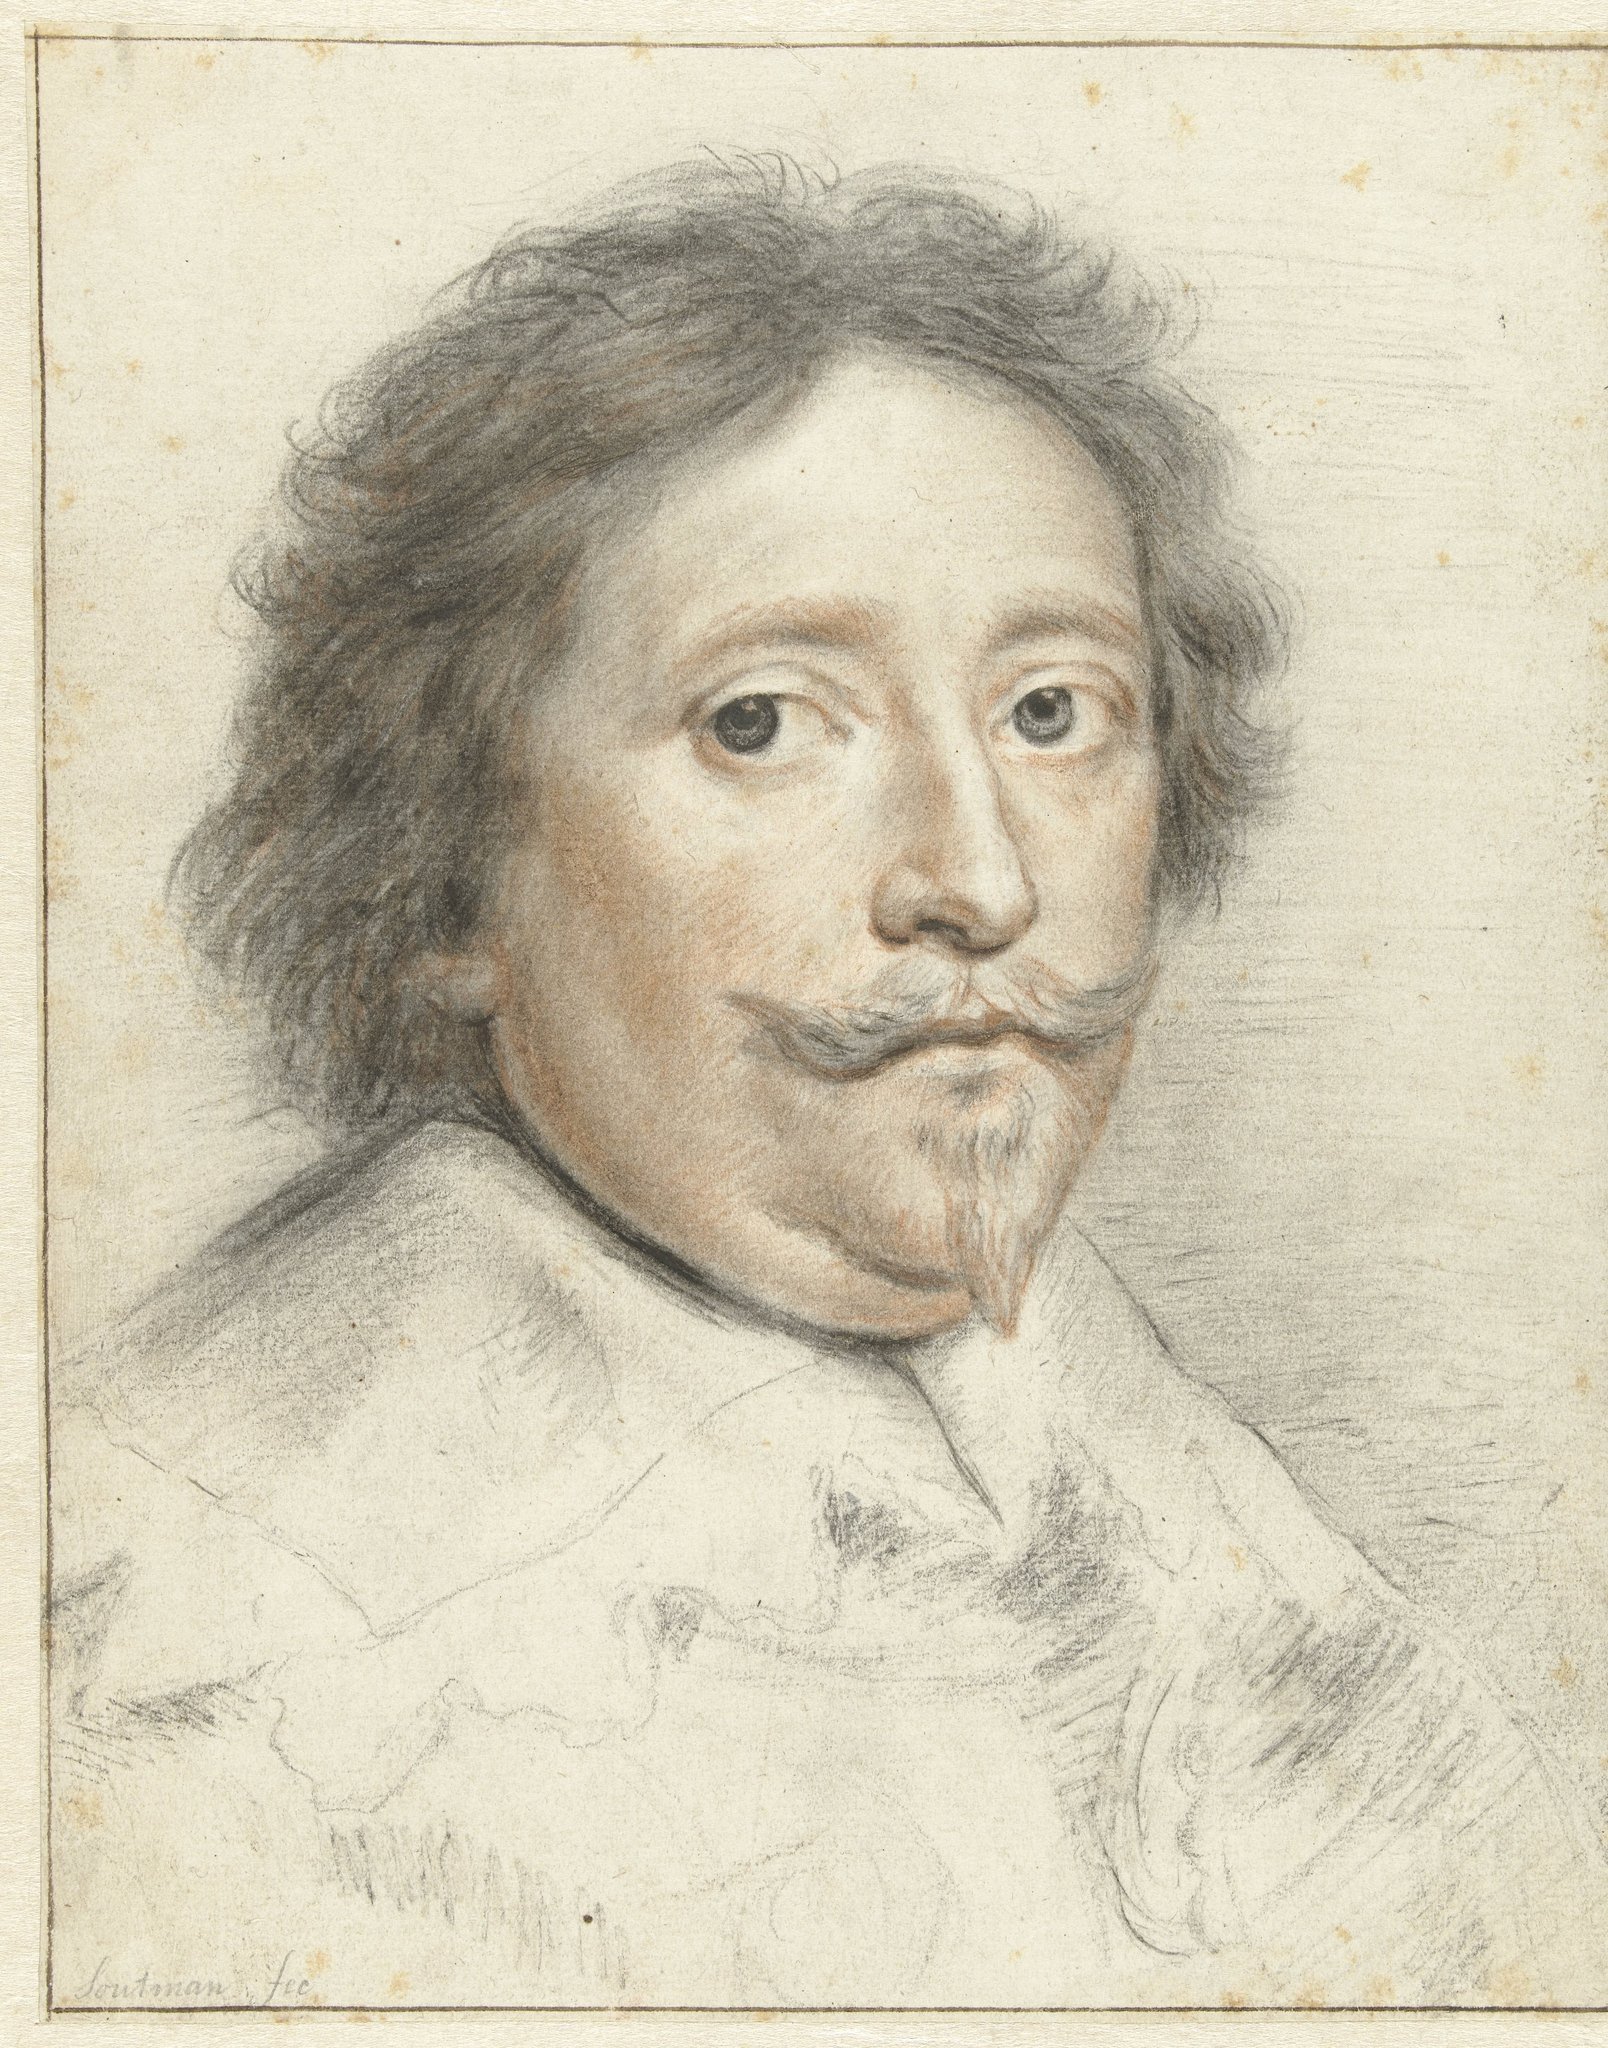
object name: design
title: Portret van Prins Frederik Hendrik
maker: pieter claesz. soutman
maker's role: draughtsman, print maker, publisher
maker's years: 1593-1657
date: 1638-1643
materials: chalk, paper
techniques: brush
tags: delft, the hague, frederick henry (prince of orange), historical persons